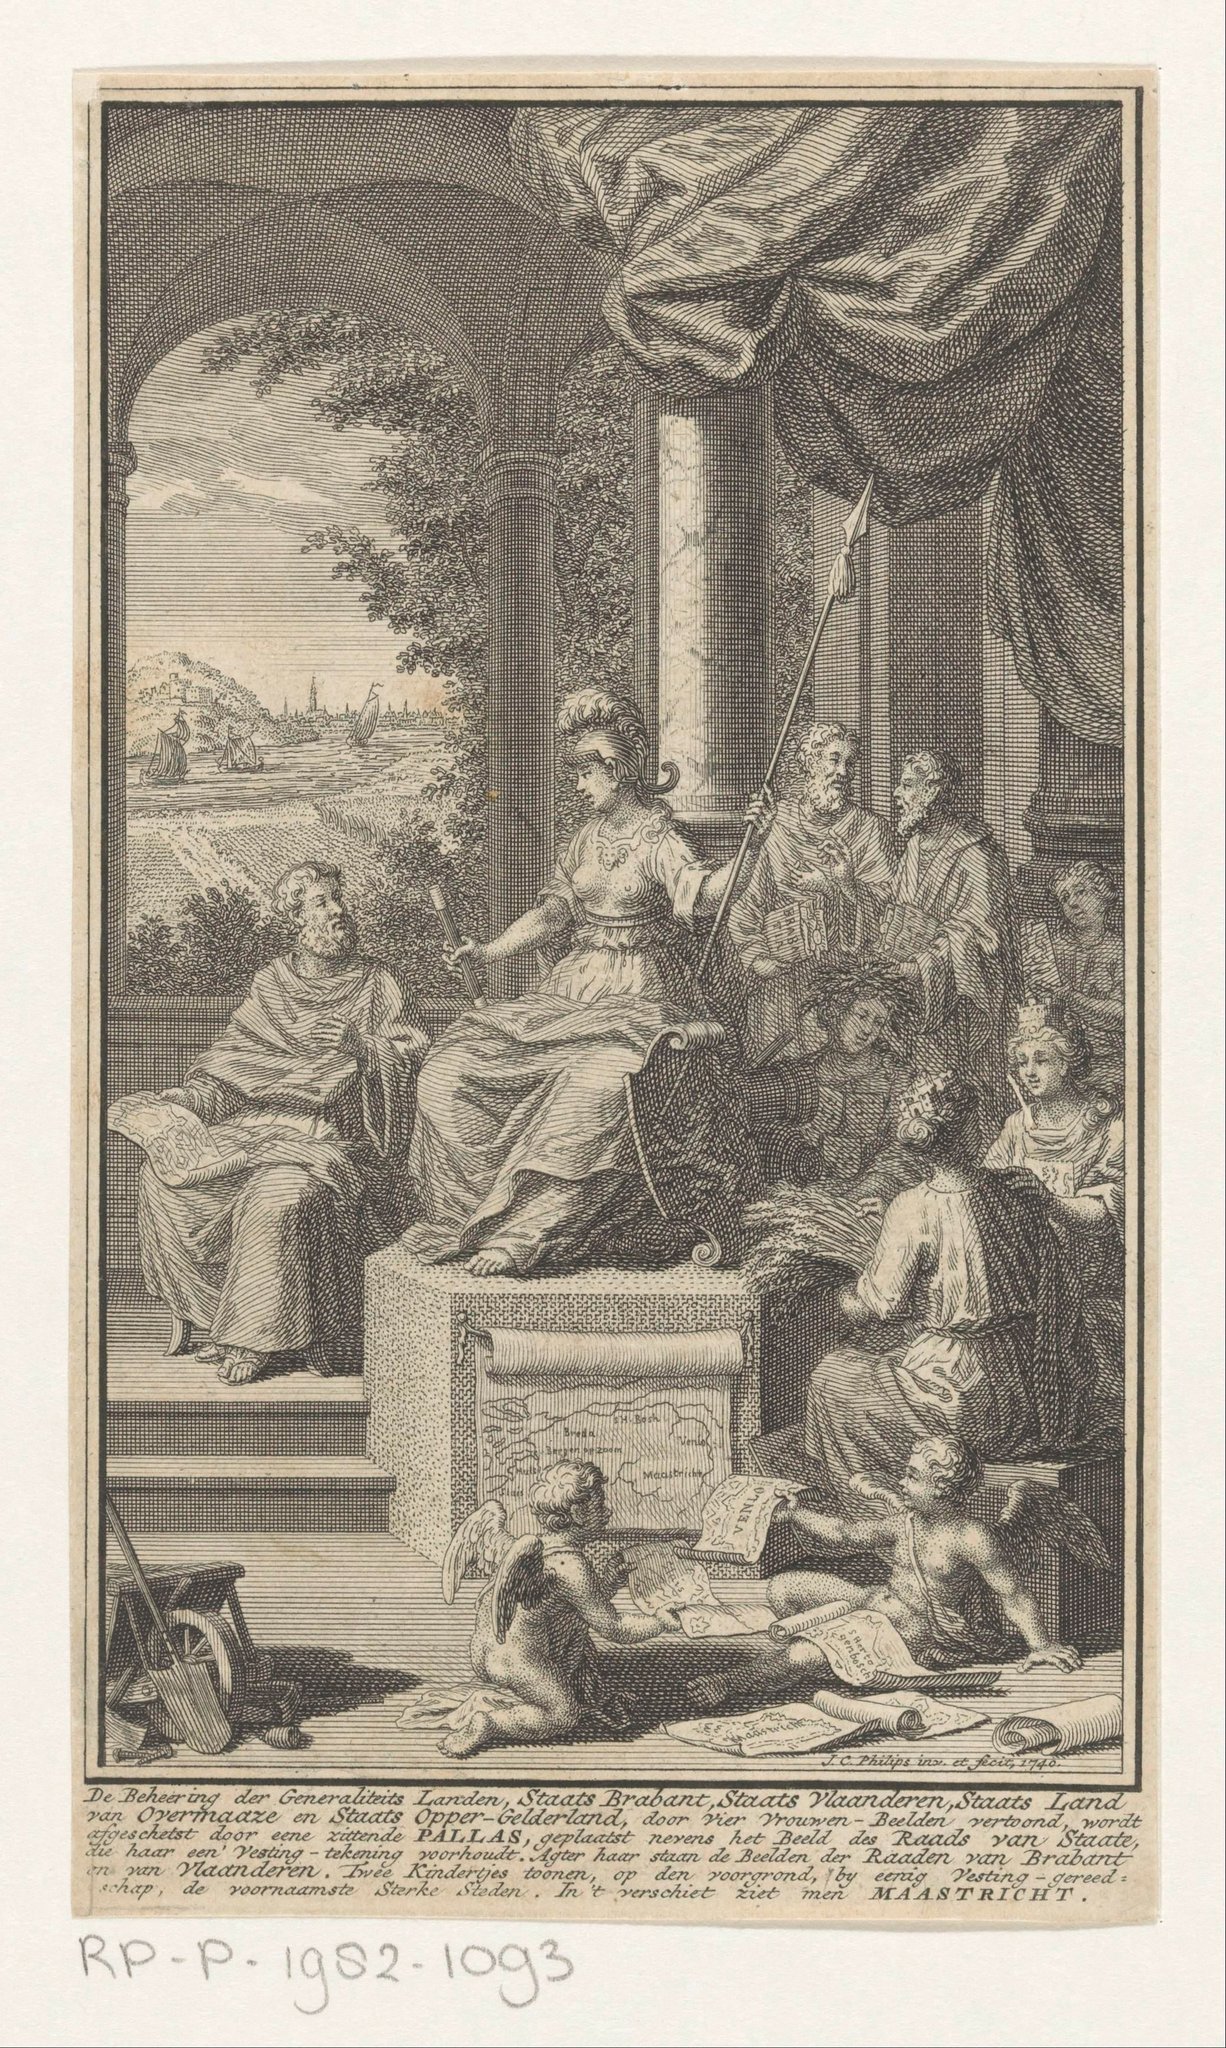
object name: titelblad, titelpagina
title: Allegorie op de beheersing van de Generaliteitslanden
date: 1740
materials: paper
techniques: engraving, etching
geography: amsterdam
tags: personifications of countries, nations, states, districts, etc., (story of) minerva (pallas, athena), maps, atlases, maastricht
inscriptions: collector's mark: Lugt 2228, collector's mark: Lugt 2760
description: Titelpagina voor: Salmon, Thomas en Wagenaar, Jan. Tegenwoordige staat der Vereenigde Nederlanden, Tweede deel. Amsterdam: Tirion, Isaak, 1740. / Titelpagina voor: Salmon, Thomas. Hedendaagsche historie of tegenwoordige staat van alle volkeren, XIIde deel. Amsterdam: Tirion, Isaak, 1740. Tussen 1739 en 1804 verscheen bij de Amsterdamse uitgever Isaak Tirion een serie van 23 delen ‘Tegenwoordige staat der Vereenigde Nederlanden’, een verzamelwerk voor een groot deel van de hand van Jan Wagenaar. Deze 23 delen waren een onderdeel van een veel groter werk, de ‘Hedendaagsche historie of tegenwoordige staat van alle volkeren’, waarvan het eerste deel in 1729 was verschenen. Beide series hebben een eigen nummering: de delen 1 t/m 23 van de serie over de Vereenigde Nederlanden zijn genummerd 11 t/m 33 van de Tegenwoordige staat van alle volkeren.